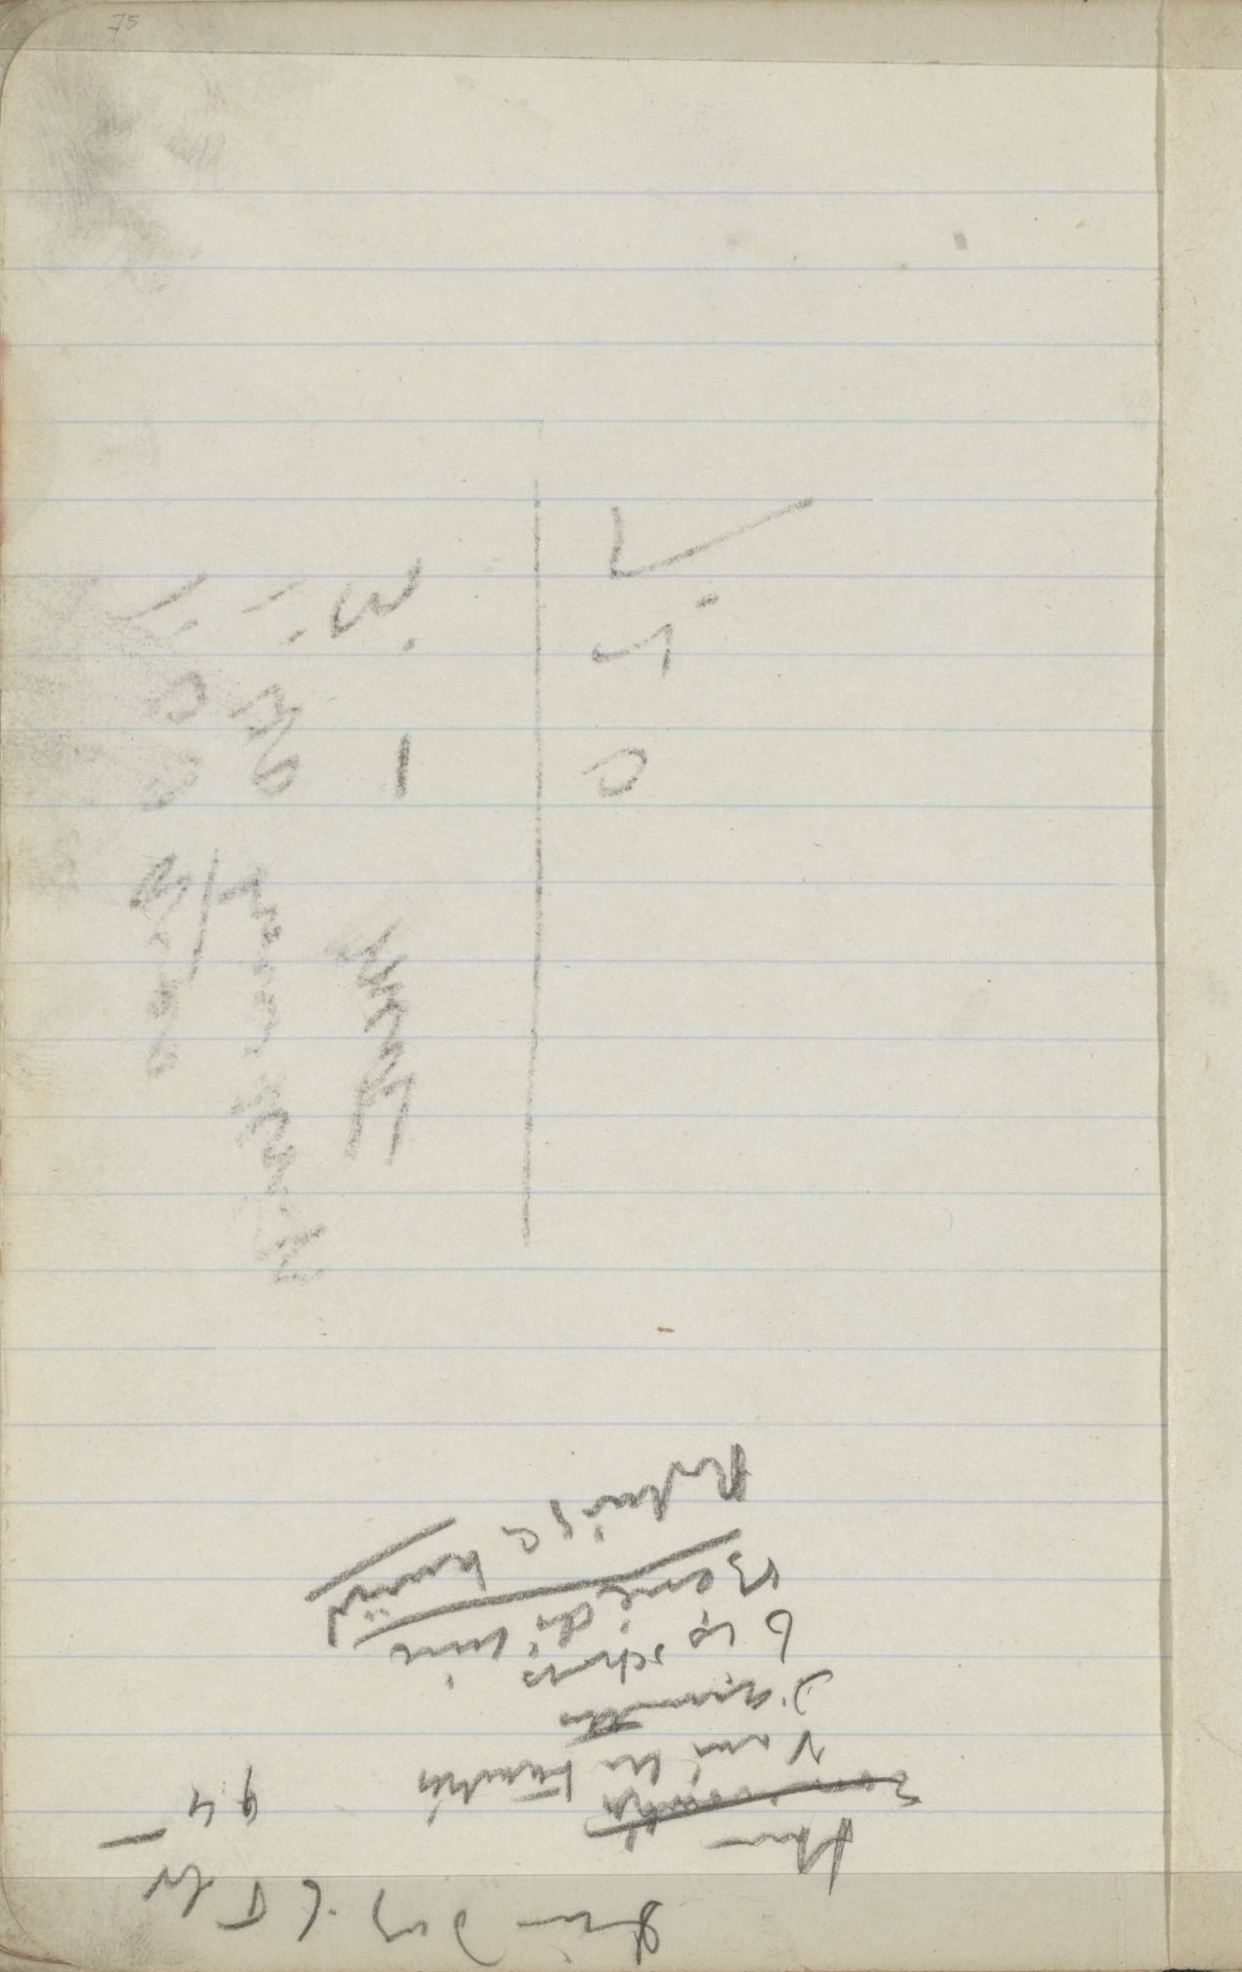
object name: sketchbook leaf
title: Annotaties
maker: george hendrik breitner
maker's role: draughtsman, painter, print maker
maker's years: 1857-1923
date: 1893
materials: chalk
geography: amsterdam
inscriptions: annotation: ‘[...] rijtuig en konijn’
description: Pagina 75 uit een schetsboek met 38 bladen.